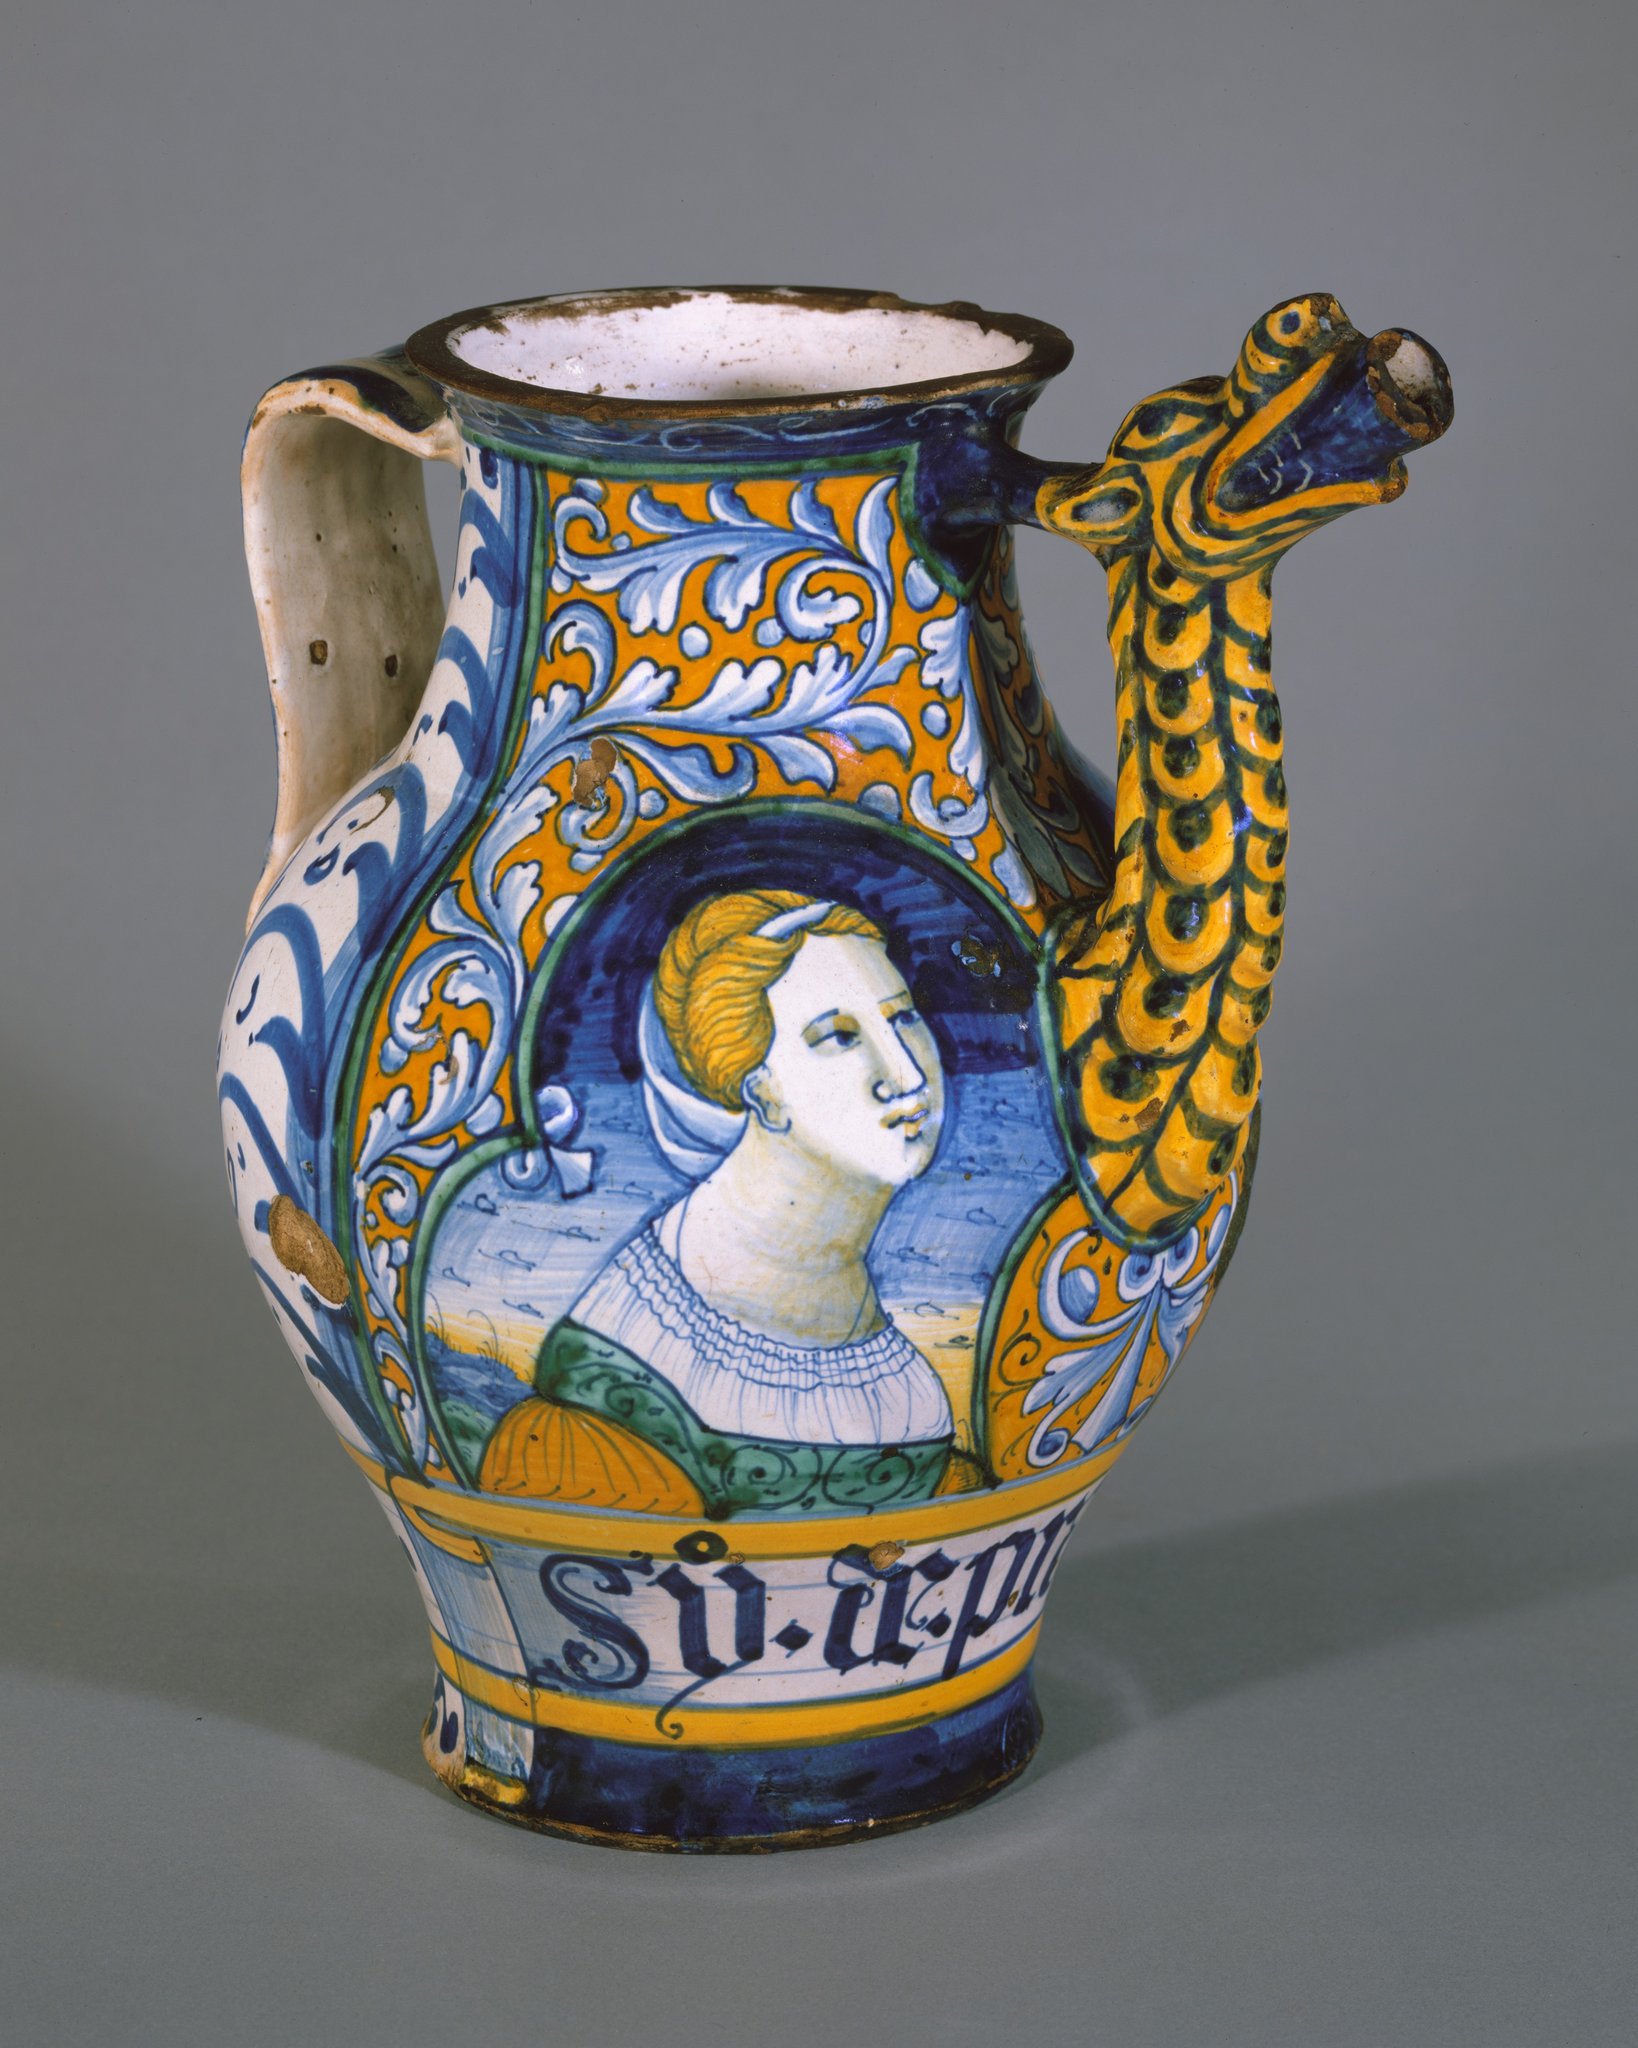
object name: apothecary jar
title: Apothecary jar (orciuolo)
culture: italian, castelli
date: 1520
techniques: maiolica, glazing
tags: women